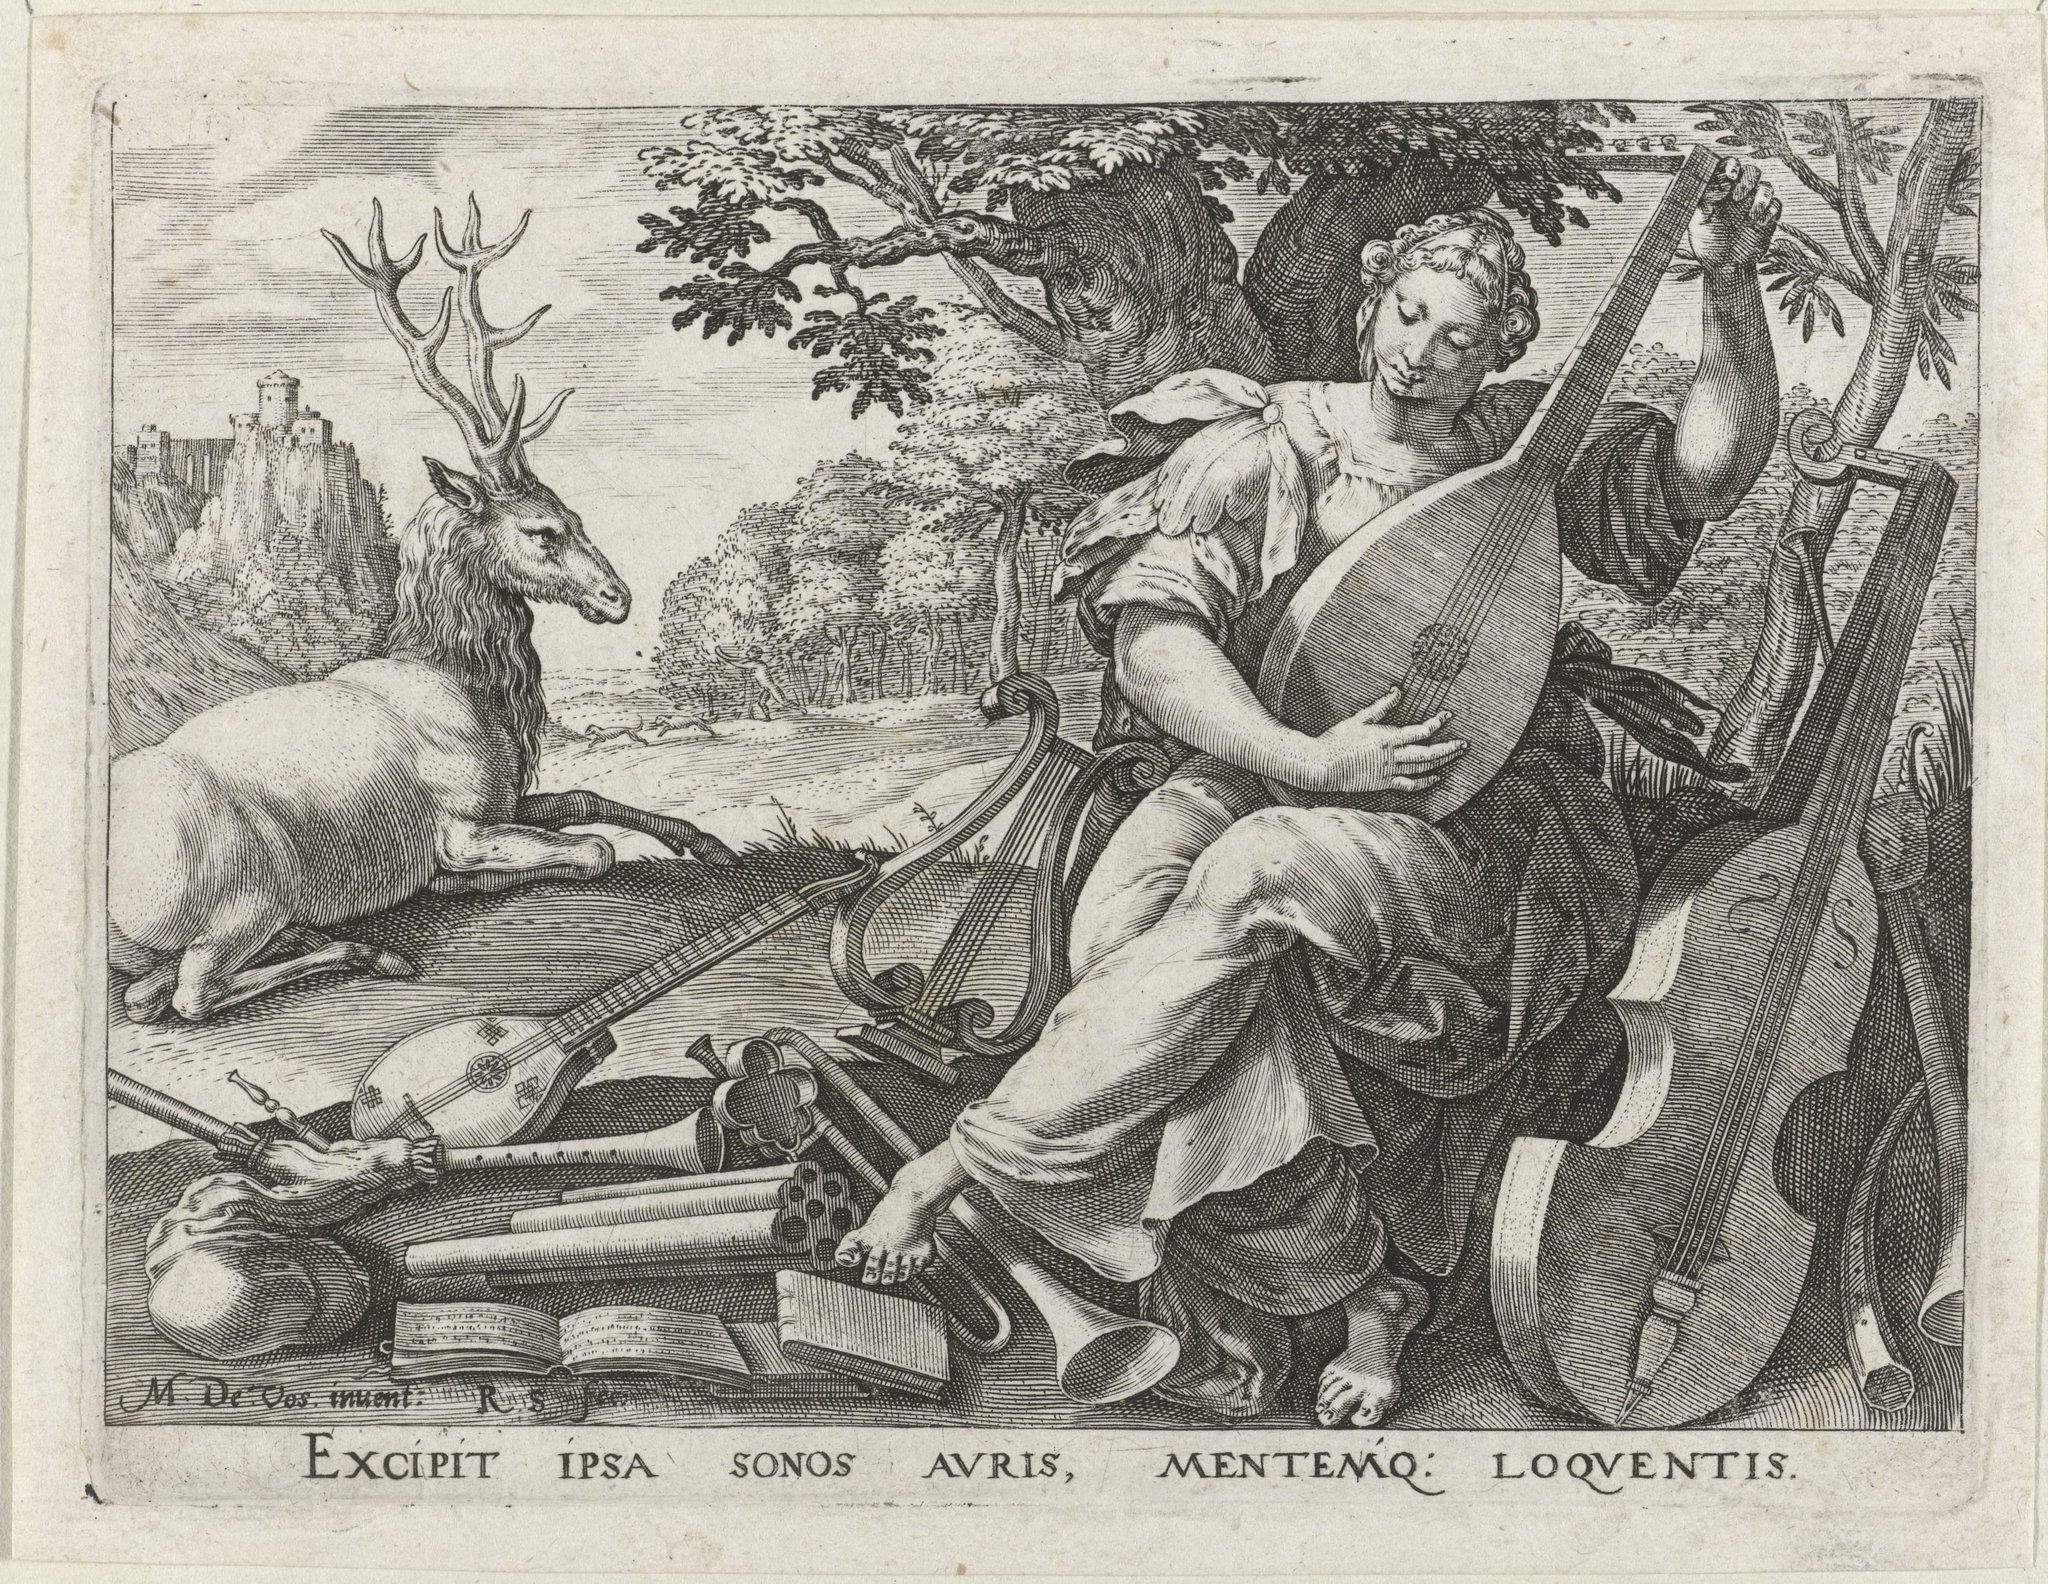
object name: print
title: De vijf zintuigen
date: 1581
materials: paper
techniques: engraving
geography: antwerp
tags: musical instruments; group of musical instruments, hoofed animals: stag, hearing, listening (one of the five senses) - aa - female human figure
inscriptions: collector's mark: Lugt 240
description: Personificatie van het Gehoor: een vrouw zit op de grond en stemt haar luit. Naast haar een viola de gamba. Om haar heen op de grond liggen verschillende muziekinstrumenten en open muziekboekjes. Linksachter een hert. De prent heeft een Latijns onderschrift en is deel van een vijfdelige serie over de zintuigen.